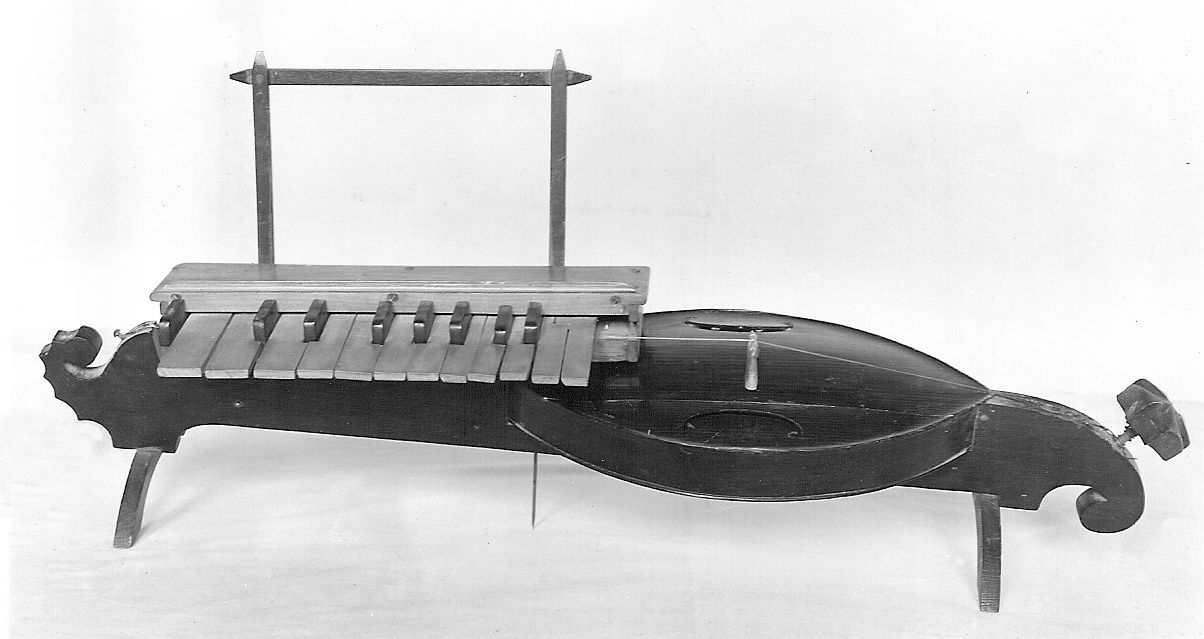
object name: violon avec clavier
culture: french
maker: joseph poussot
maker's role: maker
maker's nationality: french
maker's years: 1800-1900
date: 1890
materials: wood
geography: france